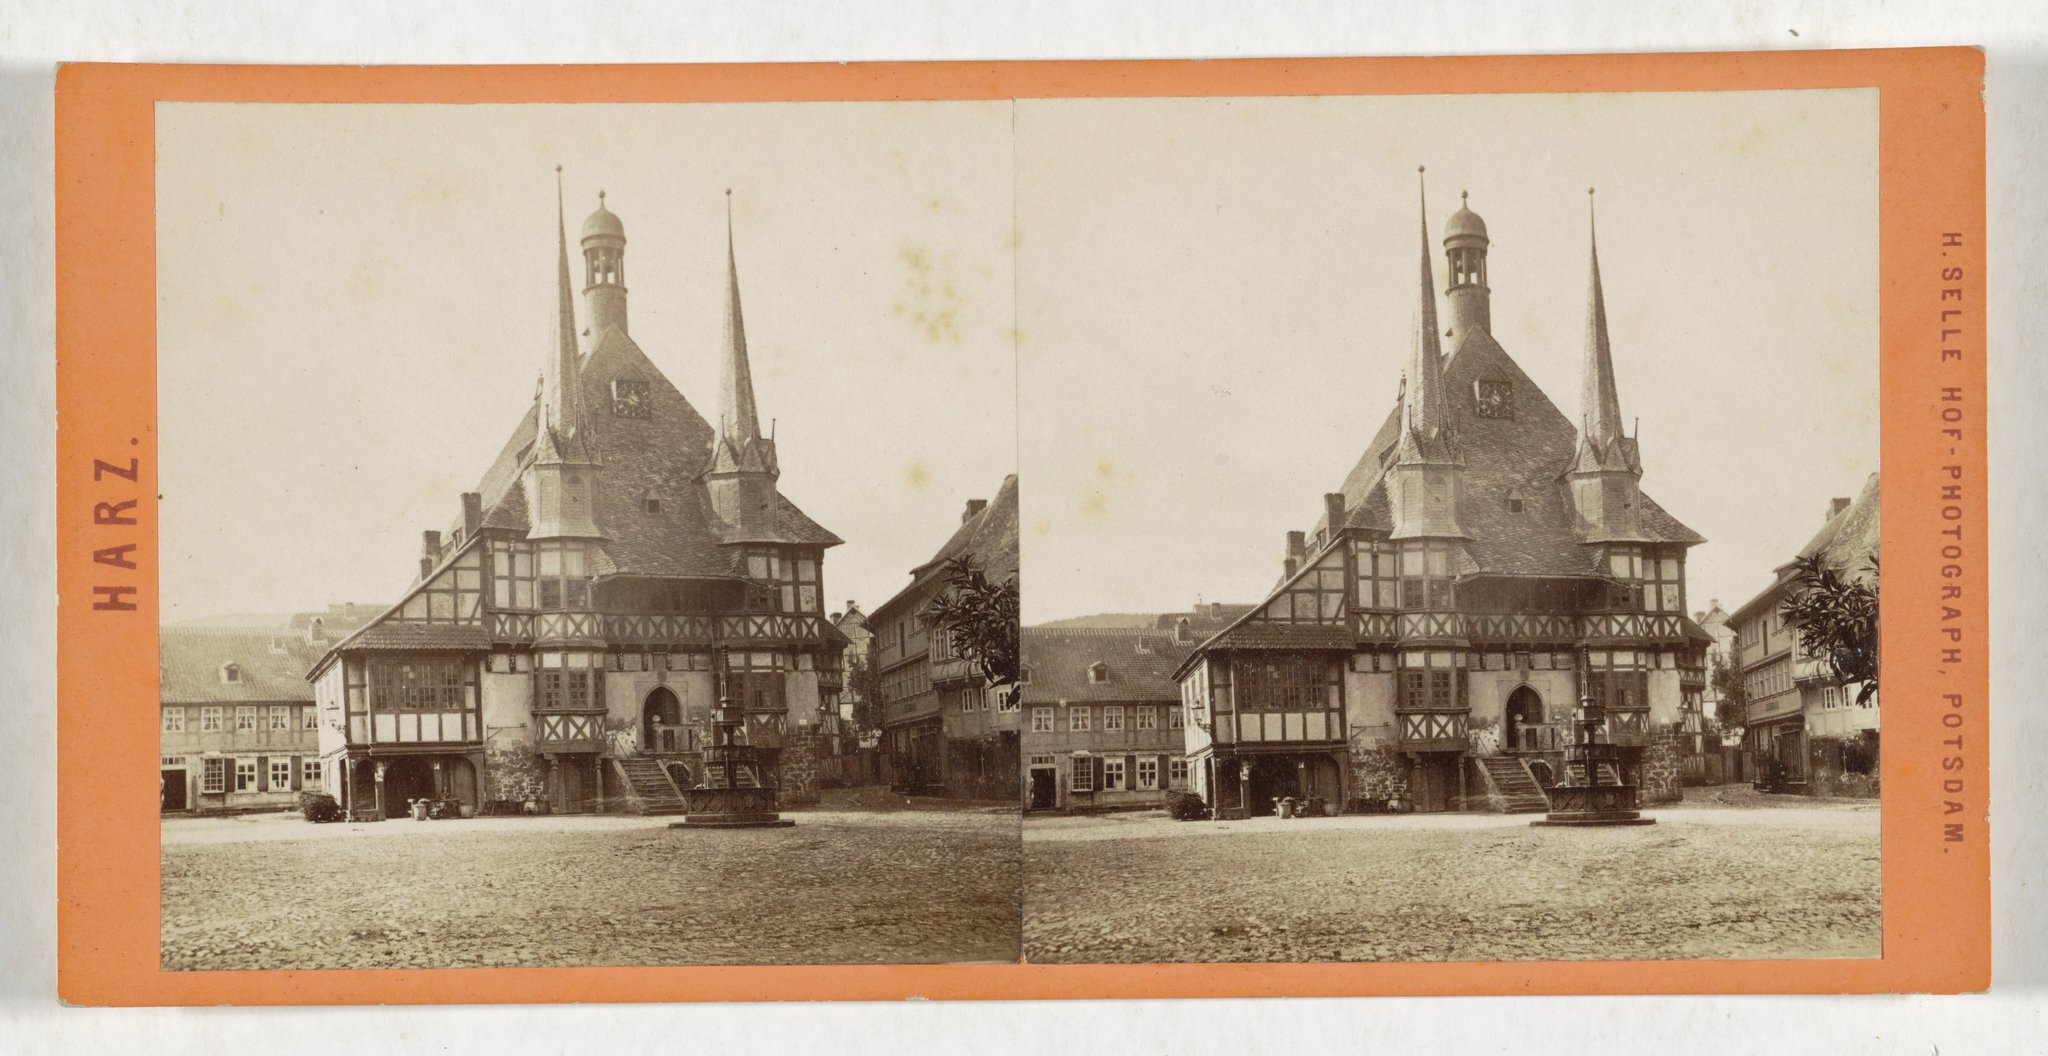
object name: stereograph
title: Stadhuis van Wernigerode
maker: hermann selle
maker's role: fotograaf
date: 1866-1870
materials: cardboard, paper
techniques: albumen print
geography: wernigerode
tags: townhall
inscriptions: inscription: ‘In Wernigerode (...) verschiedener Familien. (W.Riehl.)’, number: ‘No. 26.’, inscription: ‘Hof-Photograph. Potsdam.’